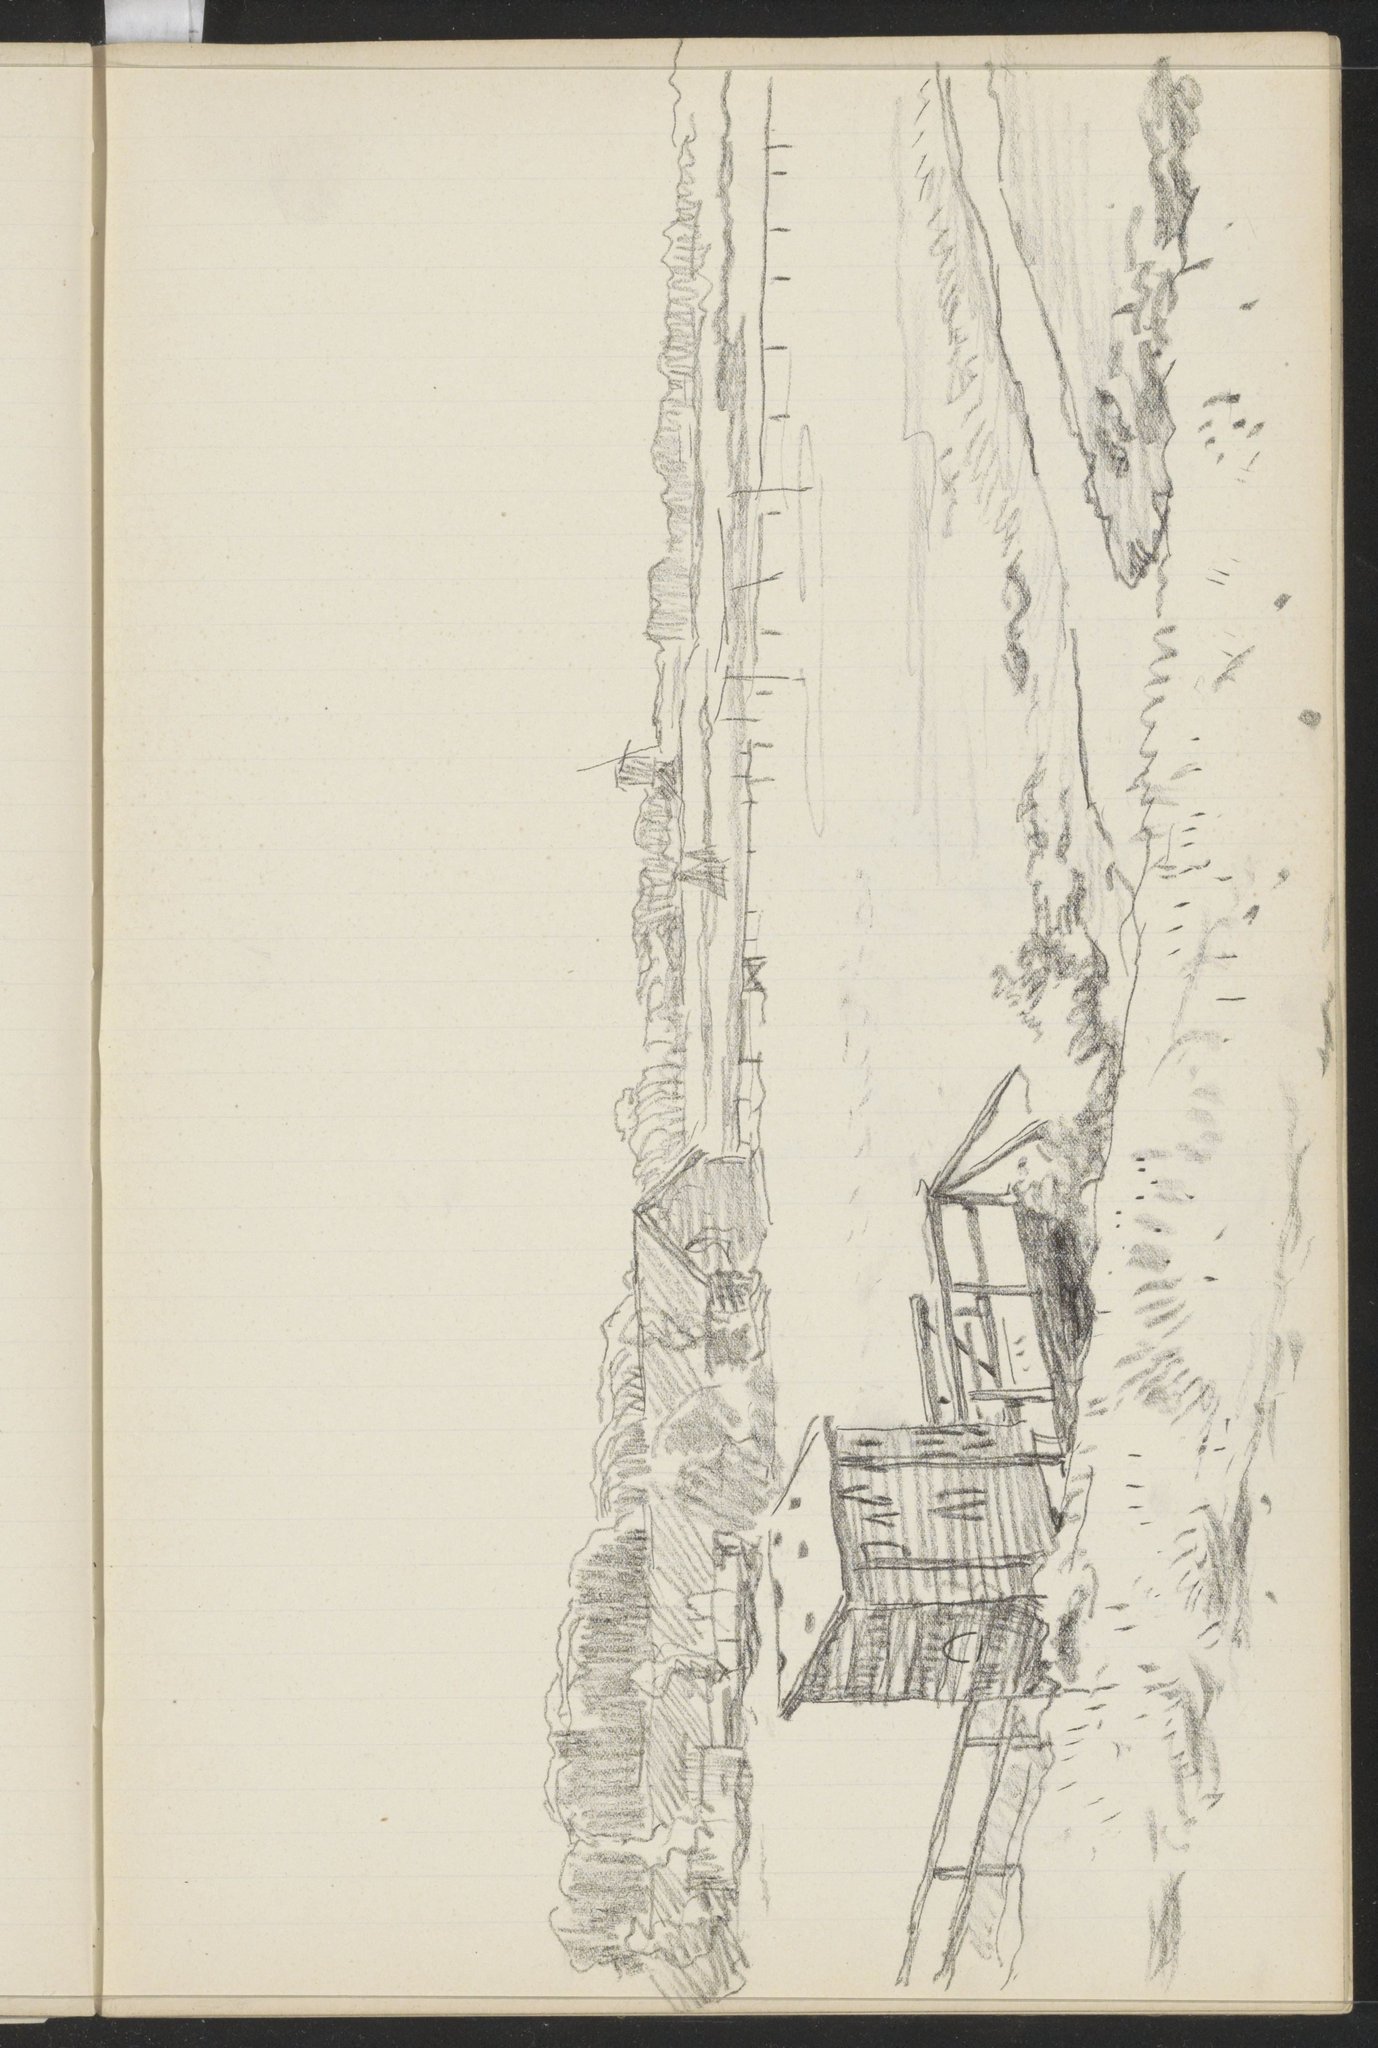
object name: sketchbook leaf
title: Weidelandschap met een brug over een sloot en een molen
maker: willem bastiaan tholen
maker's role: draughtsman, painter, print maker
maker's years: 1860-1931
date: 1900-1931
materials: chalk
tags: city-view, and landscape with man-made constructions, landscapes with waters, waterscapes, seascapes (in the temperate zone), meadow, pasture, windmill in landscape, bridge, small canal, ditch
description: Blad 27 recto uit een schetsboek met 55 bladen.